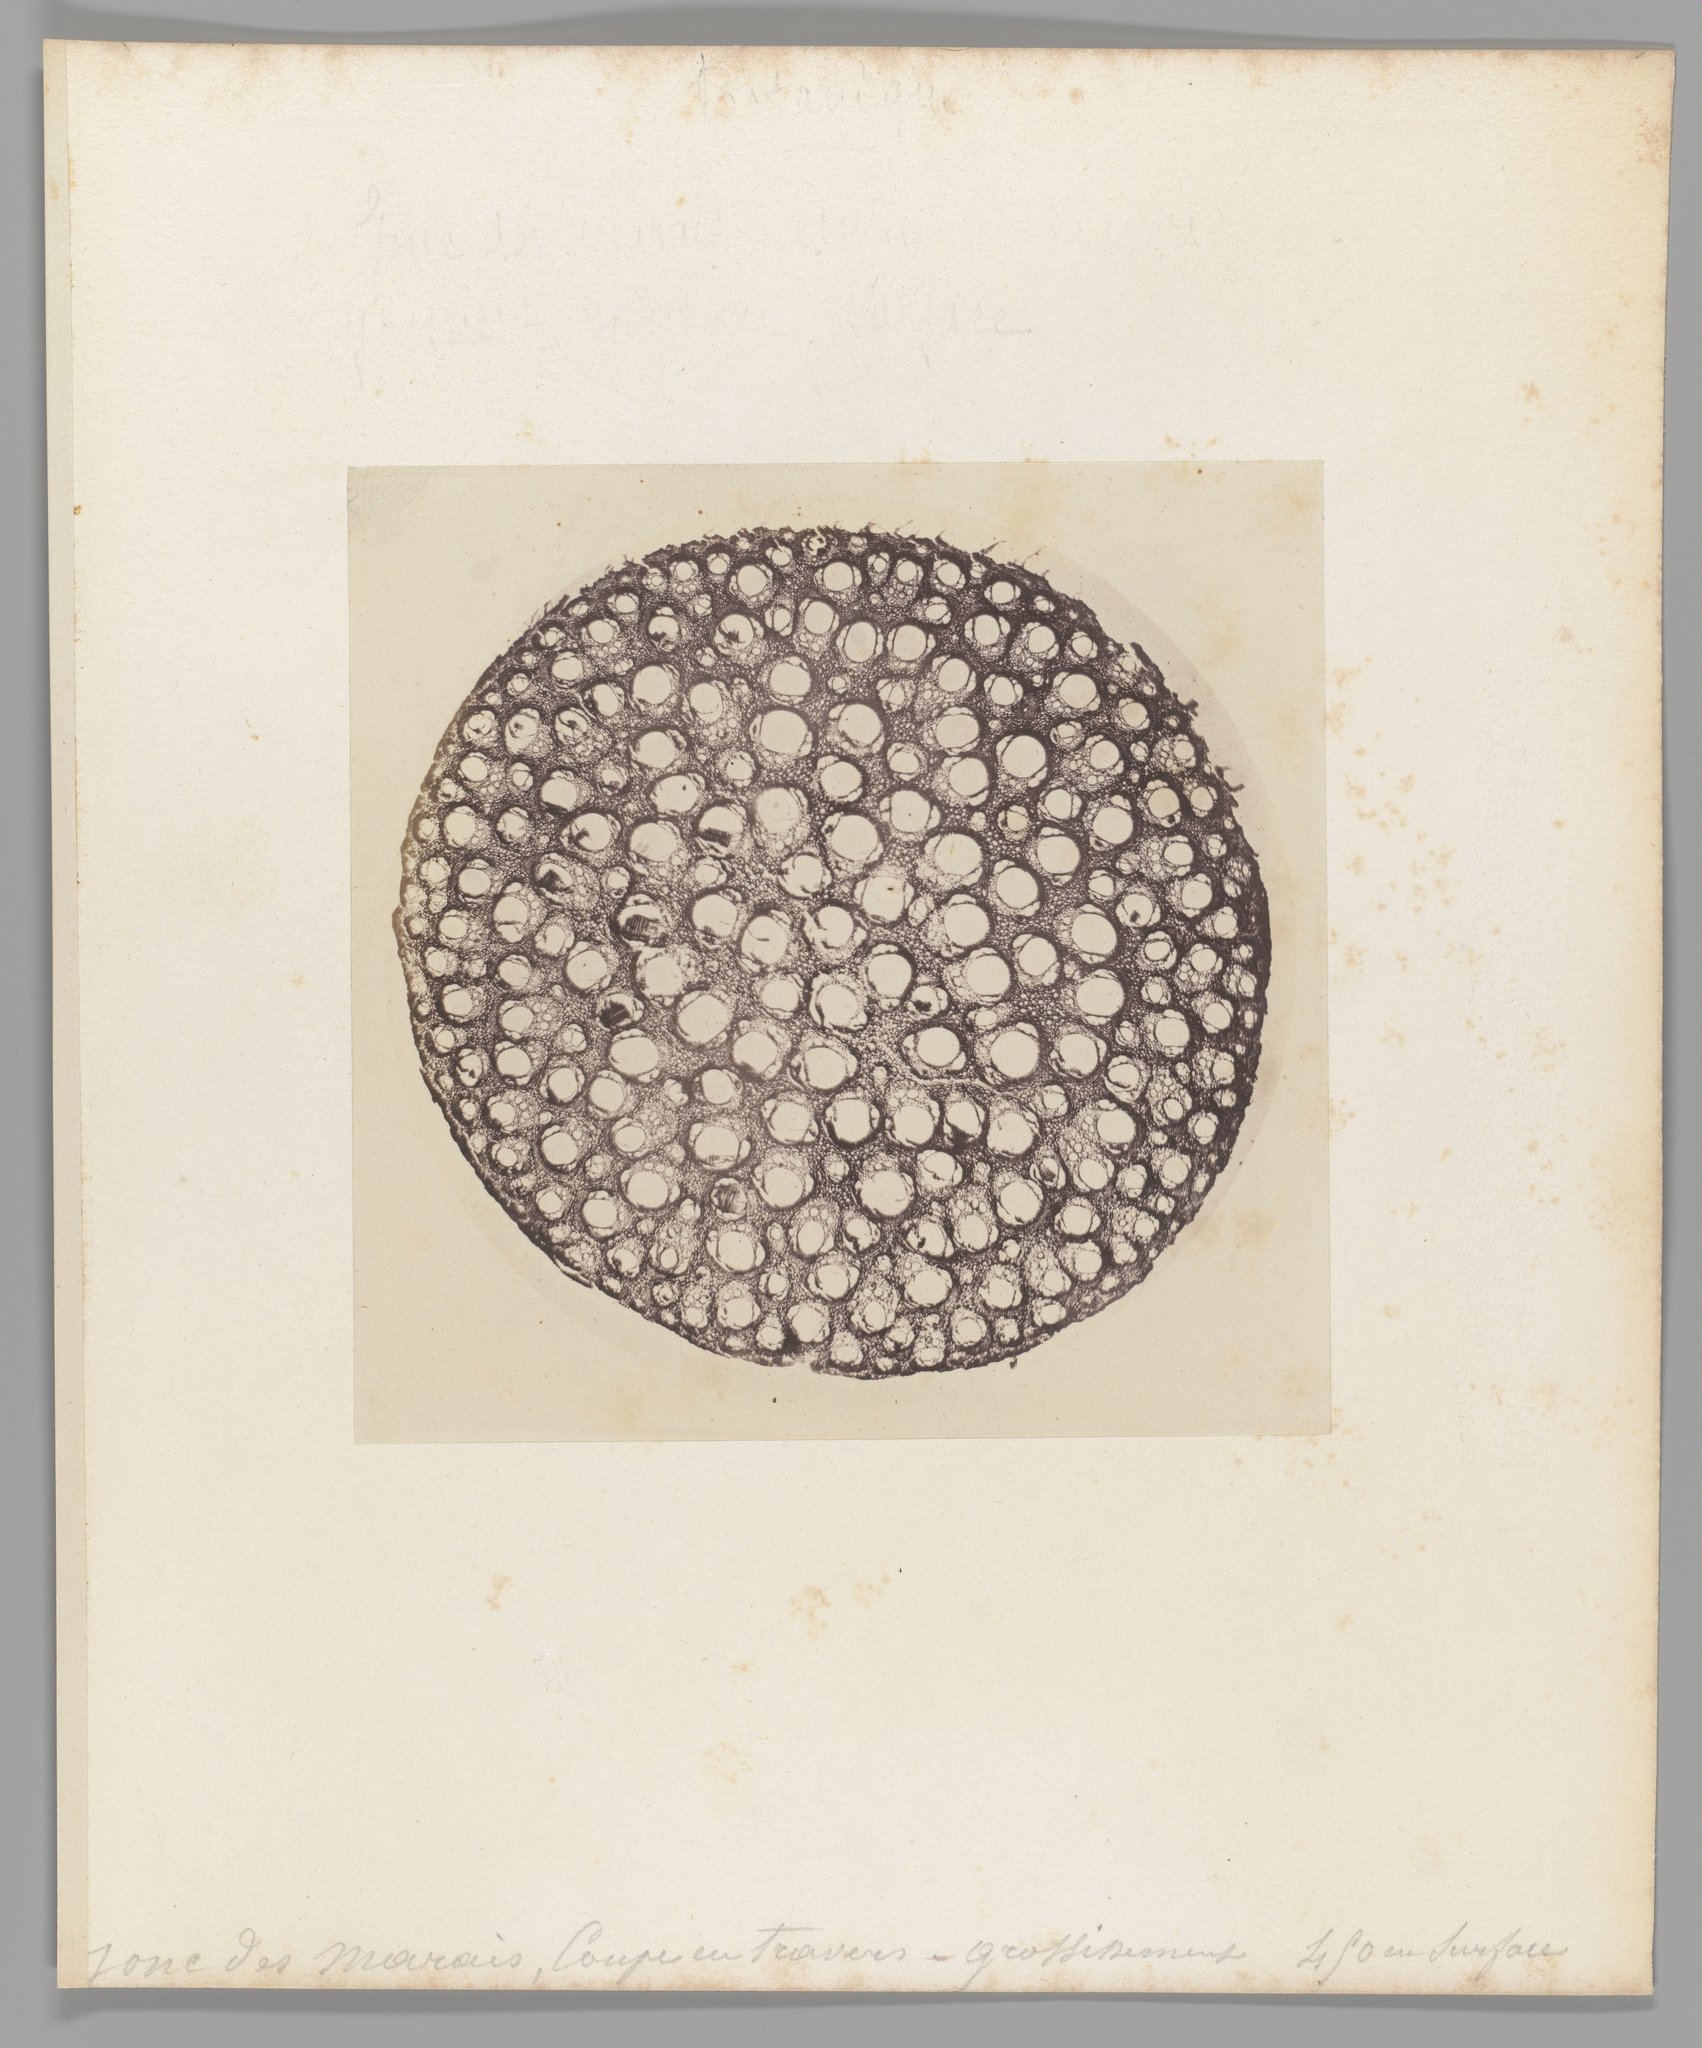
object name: photograph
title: [Untitled]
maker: auguste-adolphe bertsch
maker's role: artist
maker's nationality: french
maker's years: 1813-1871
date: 1853-1857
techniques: salted paper print